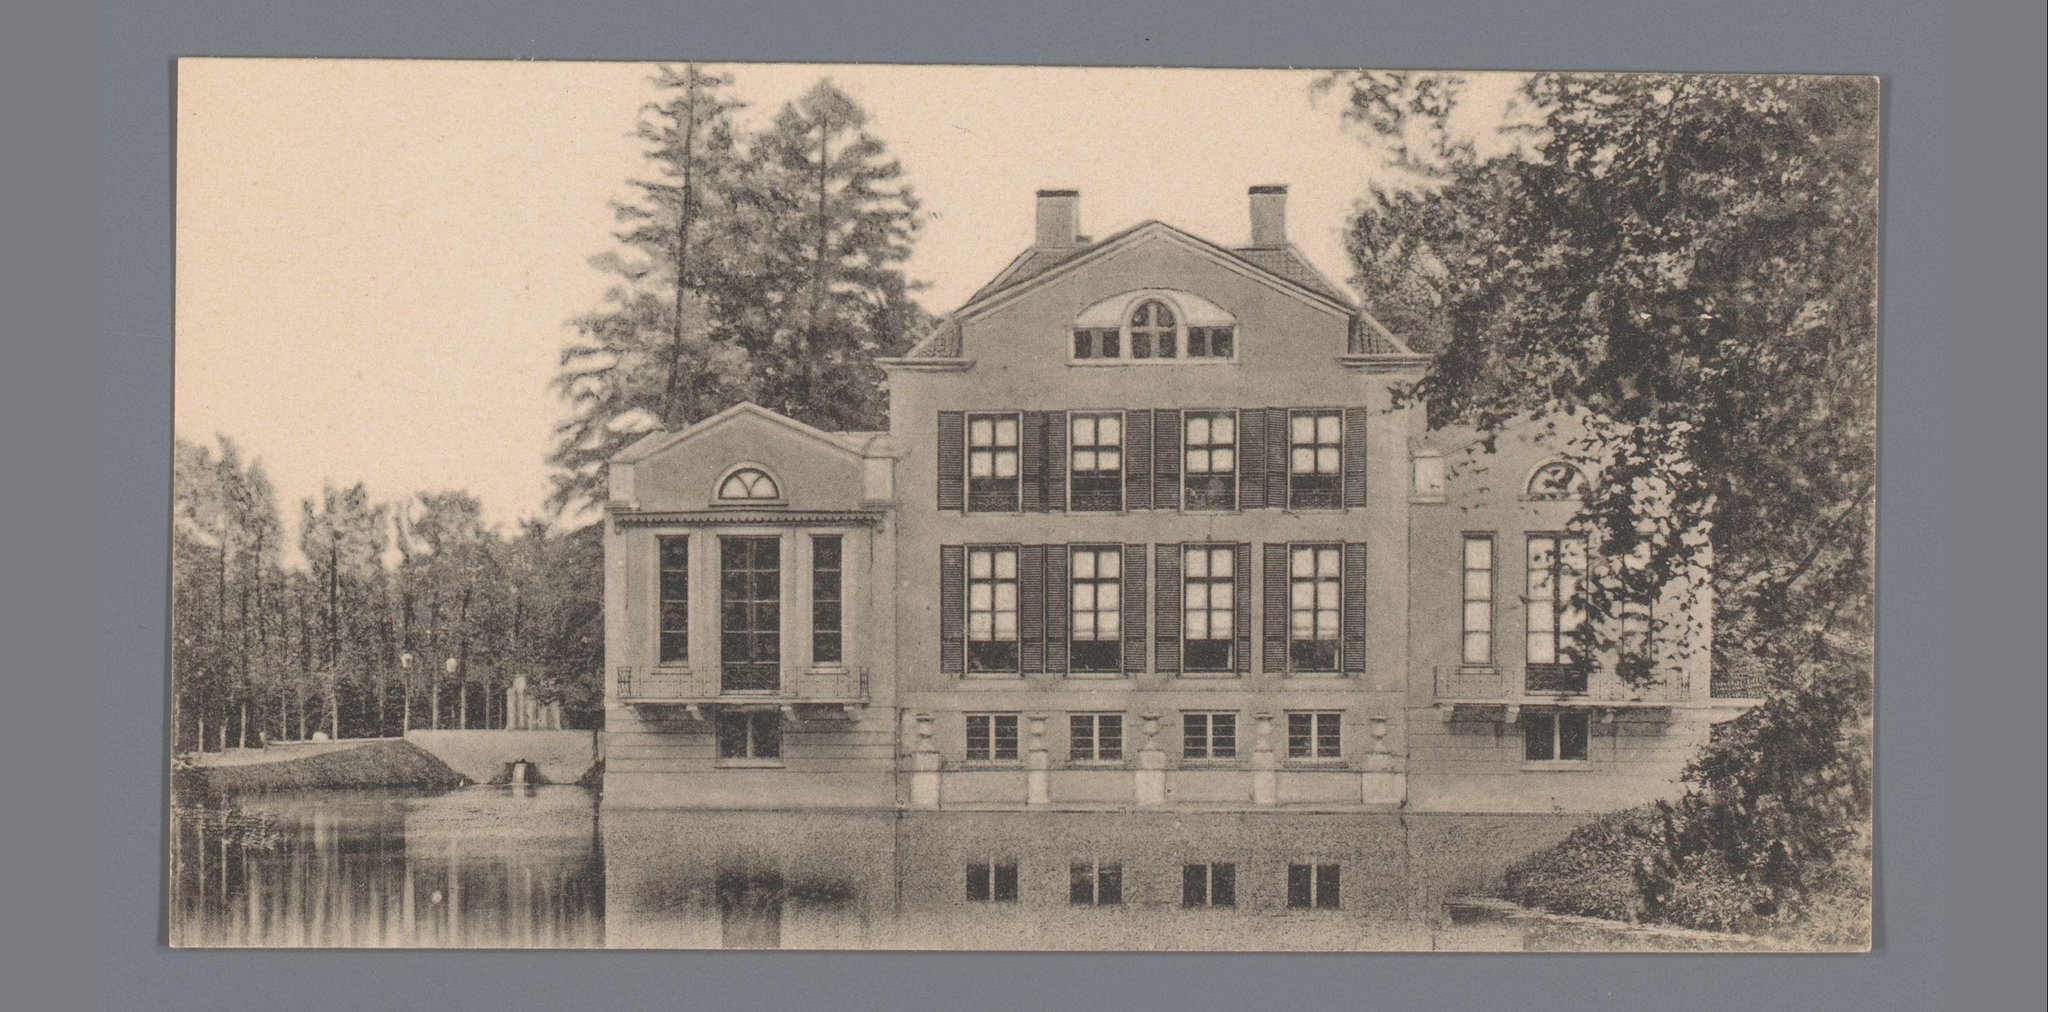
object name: photomechanical print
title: Gezicht op een landhuis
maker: Anonymous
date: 1880-1940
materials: paper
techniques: photograph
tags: rural housing, e.g. country-house, villa, cottage, façade (of house or building)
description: Op verso regels om te versturen als briefkaart.